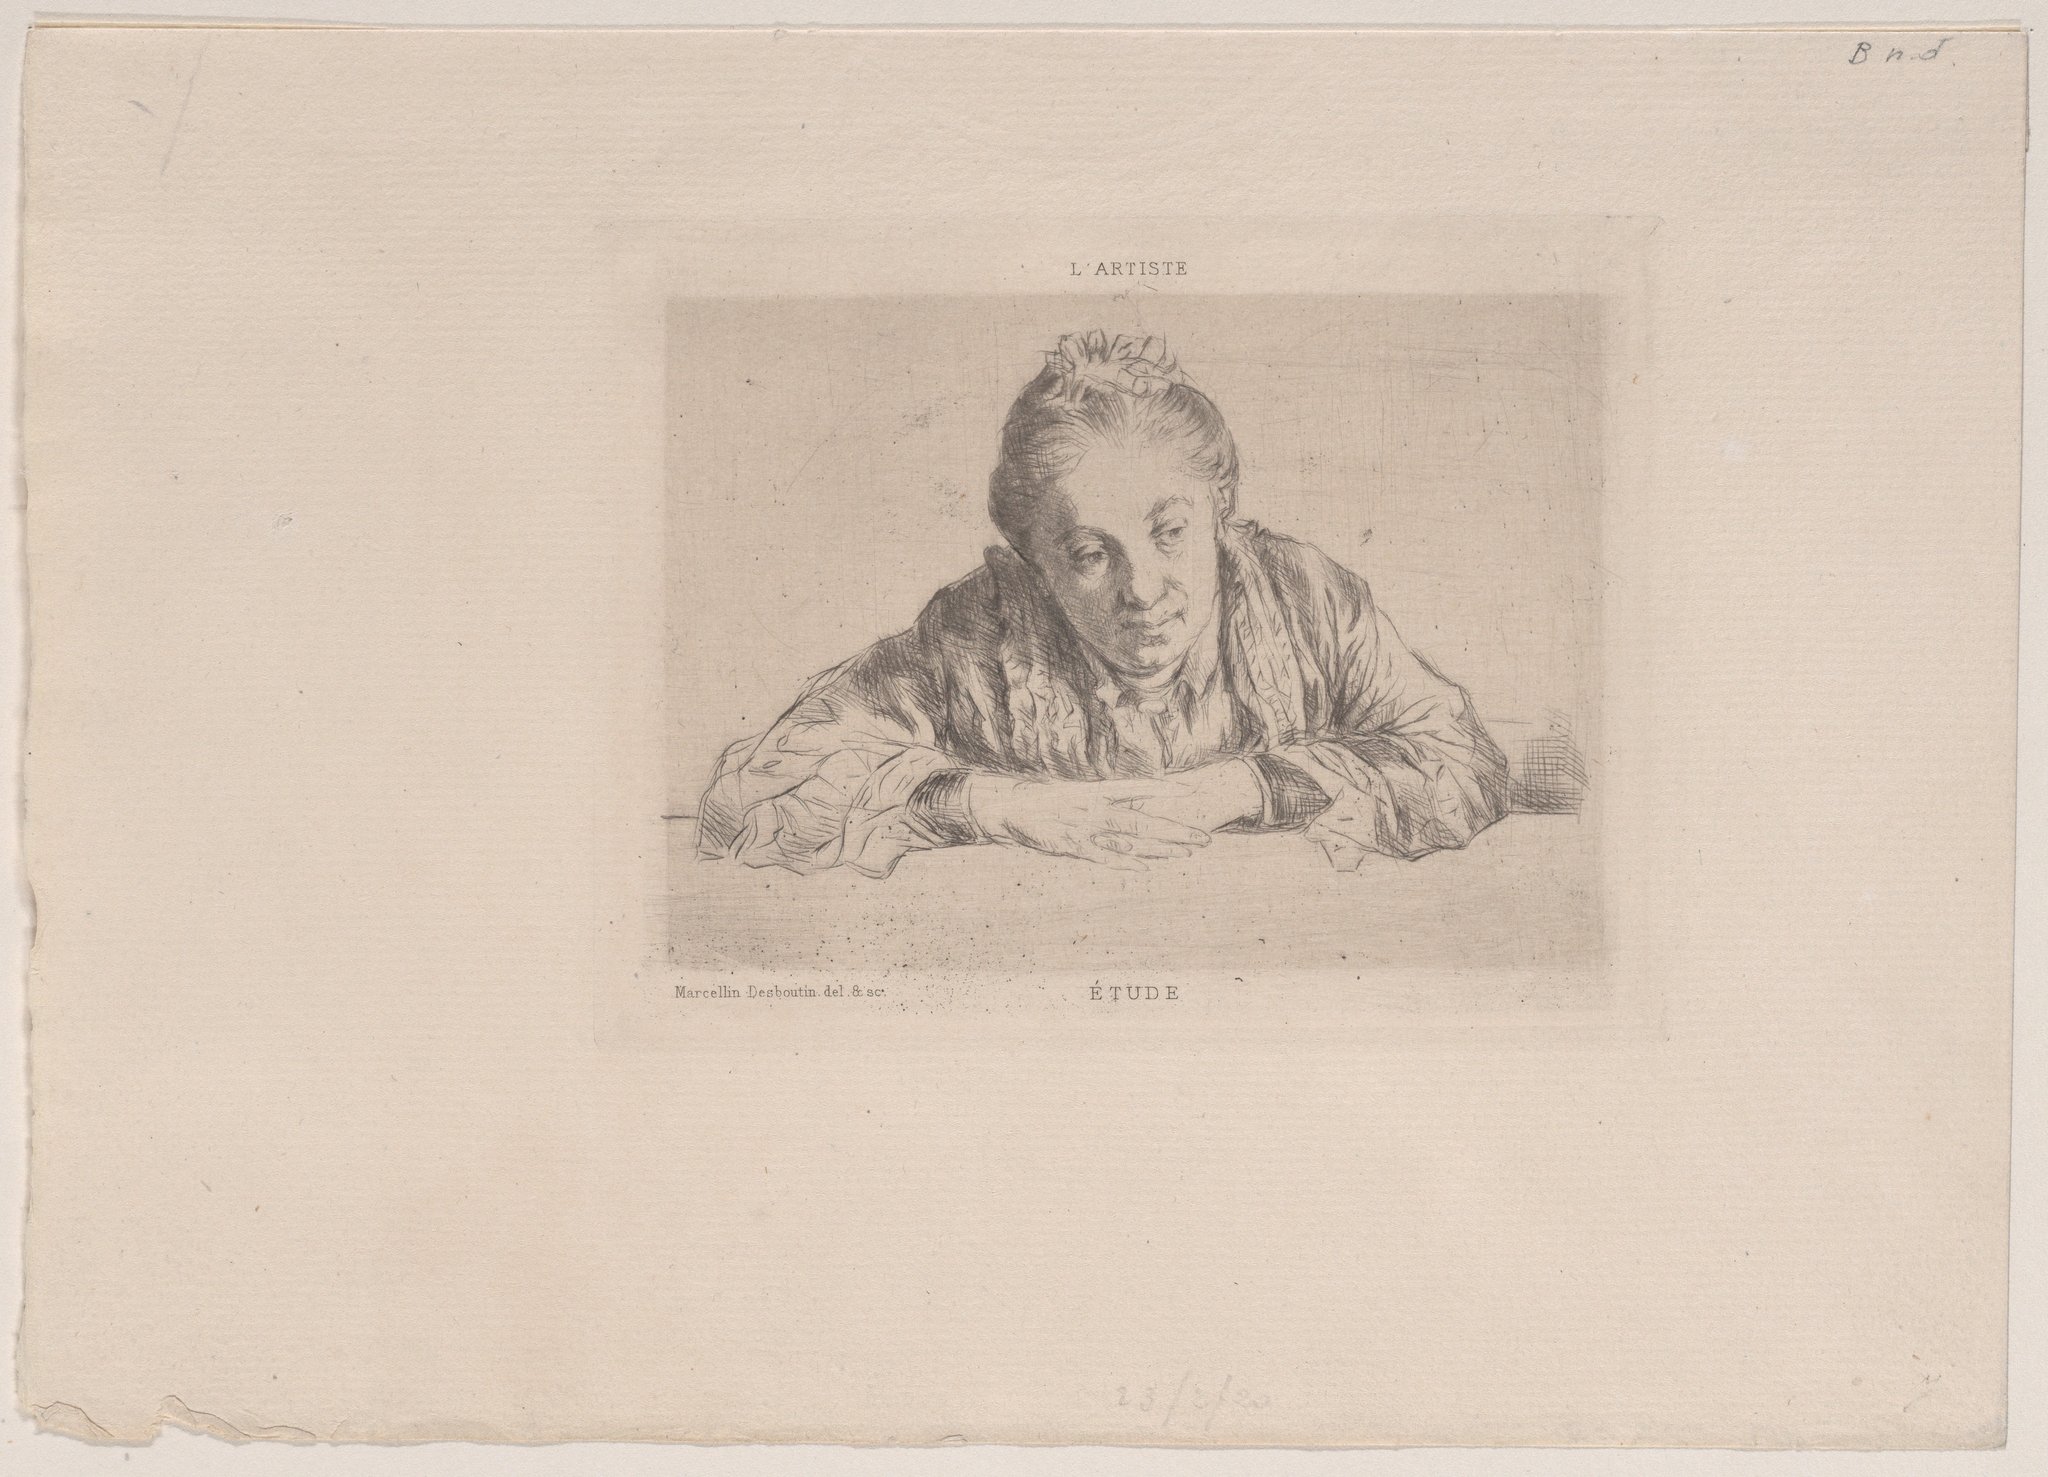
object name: print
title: Étude, ou femme accoudée, from "L'Artiste"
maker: marcellin desboutin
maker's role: artist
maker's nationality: french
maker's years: 1823-1902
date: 1889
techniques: drypoint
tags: women